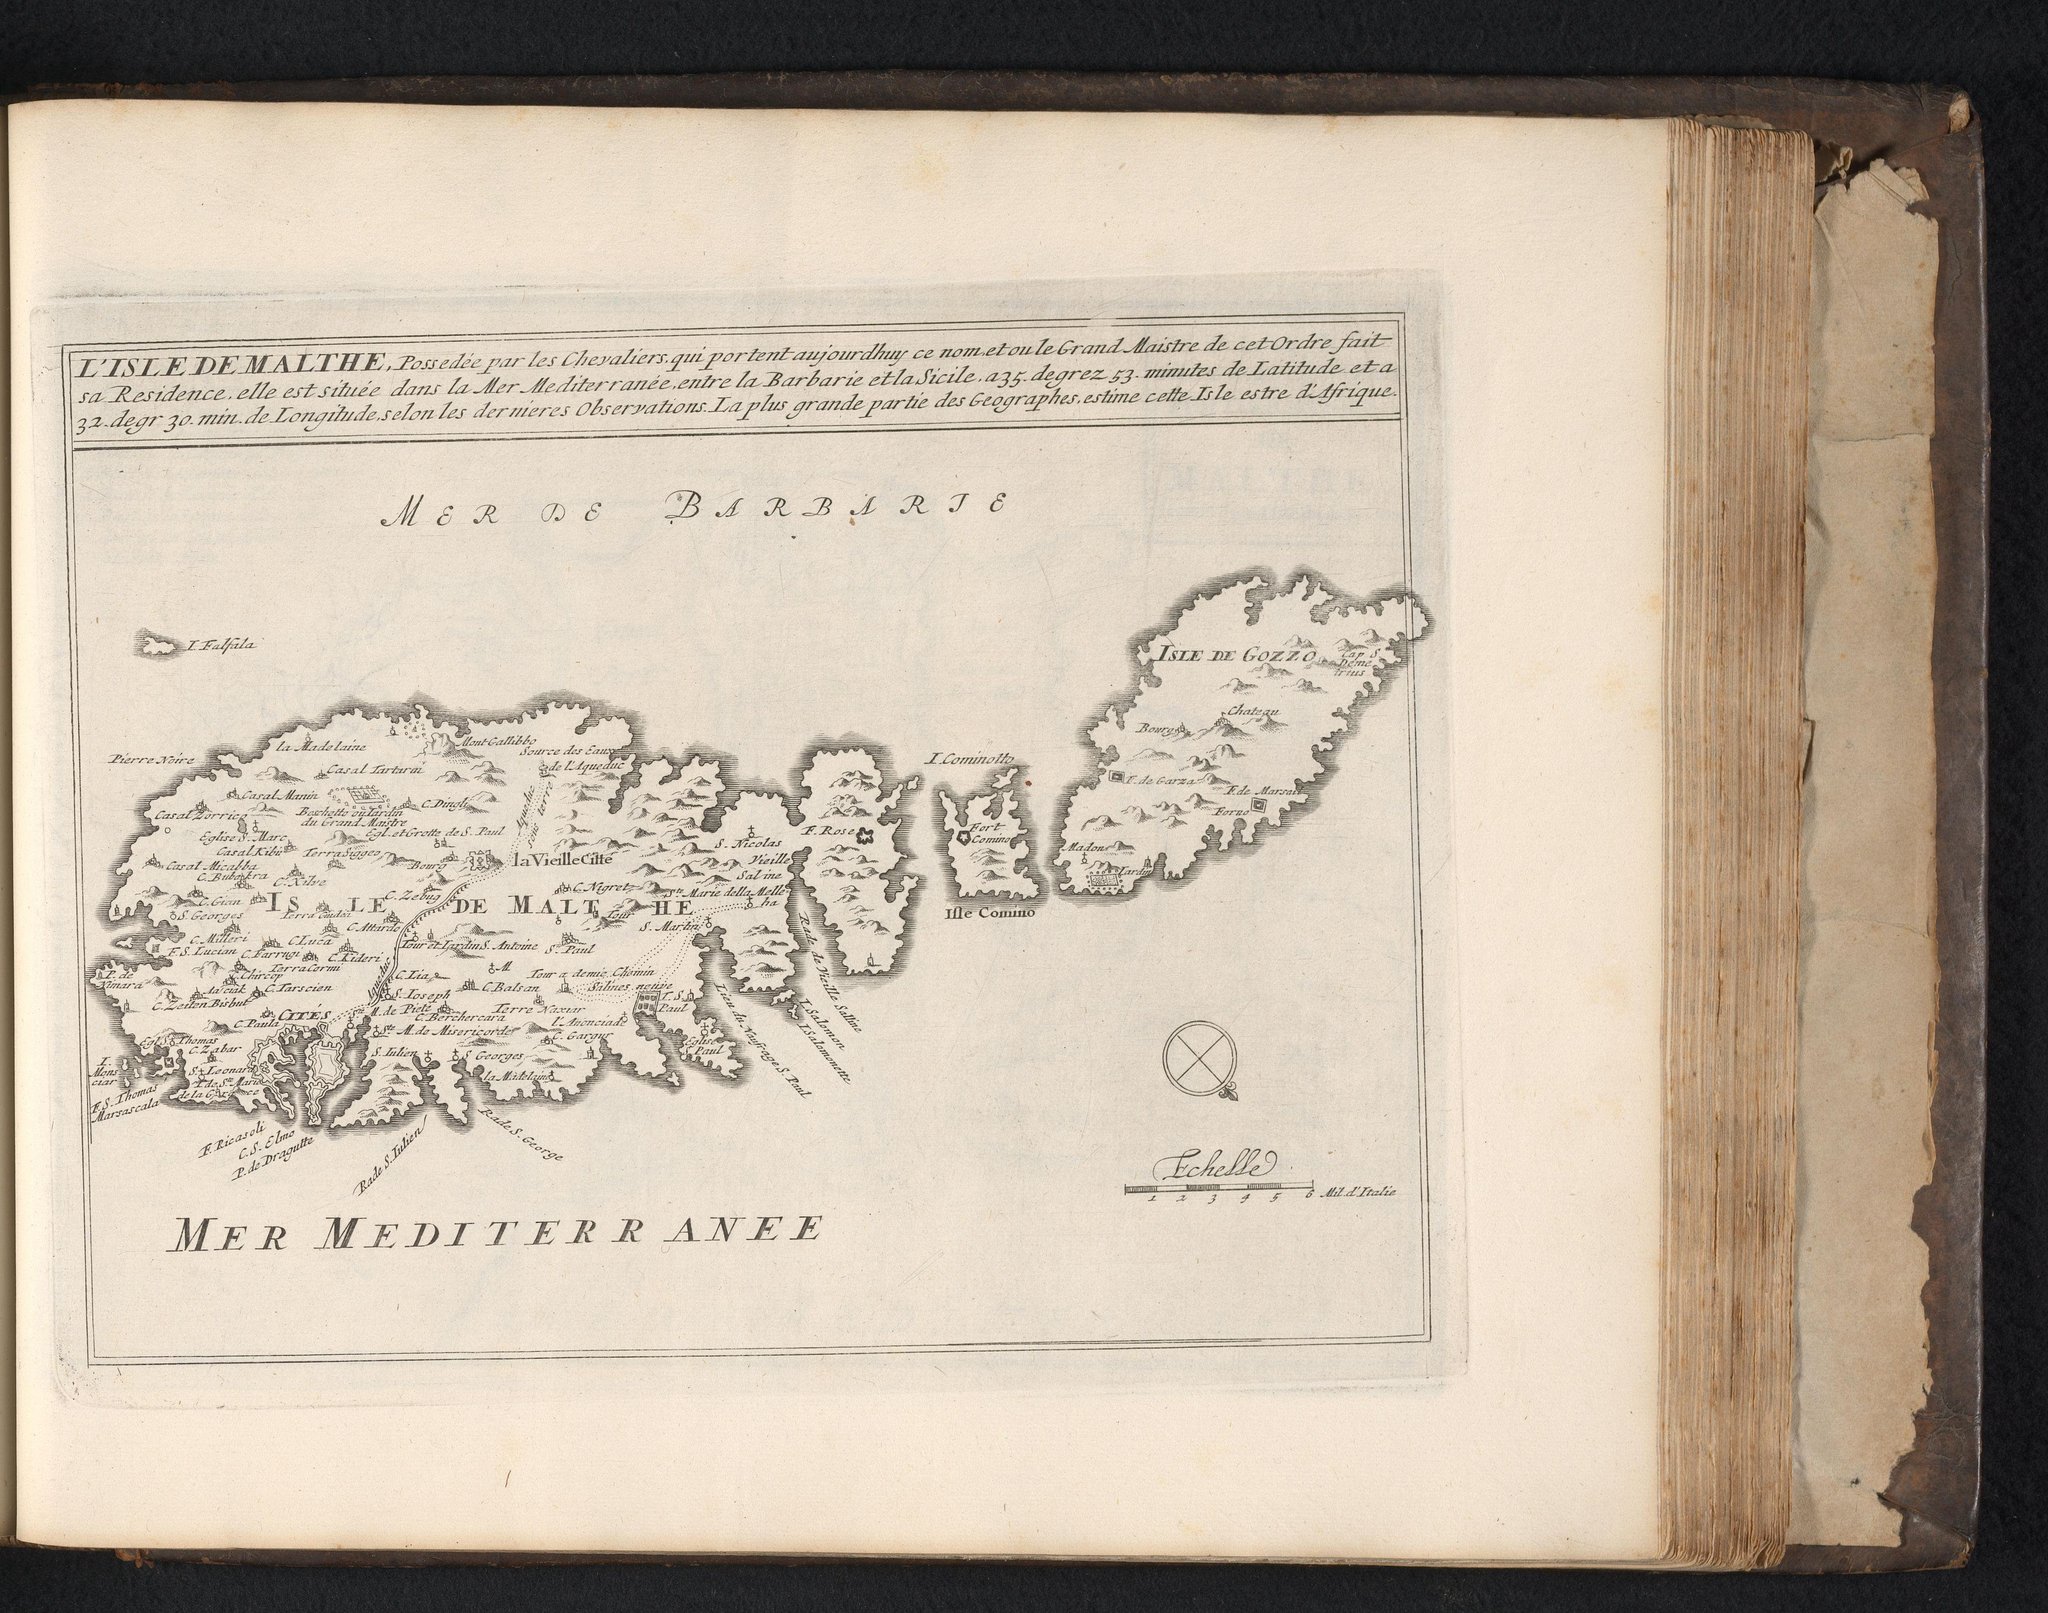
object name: print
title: Les forces de l'Europe, ou description des principales villes, avec leurs fortifications : dessignées par les meilleurs ingenieurs, particulierement celles (...) de la France, dont les plans ont esté levez par M. de Vauban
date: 1695-1697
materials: paper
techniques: engraving, etching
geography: paris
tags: maps of separate countries or regions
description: Kaart van het eiland Malta. Onderdeel van het achtste deel (1697) van het prentwerk waarin gebundeld zijn de acht delen van Les forces de l'Europe uitgegeven tussen 1693-1697. Het prentwerk bestaat uit 175 platen met plannen (afkomstig van Sébastien Le Prestre, Seigneur de Vauban) van vermaarde sterke steden en vestingen in de Negenjarige Oorlog. Titel en opschriften in het Frans.